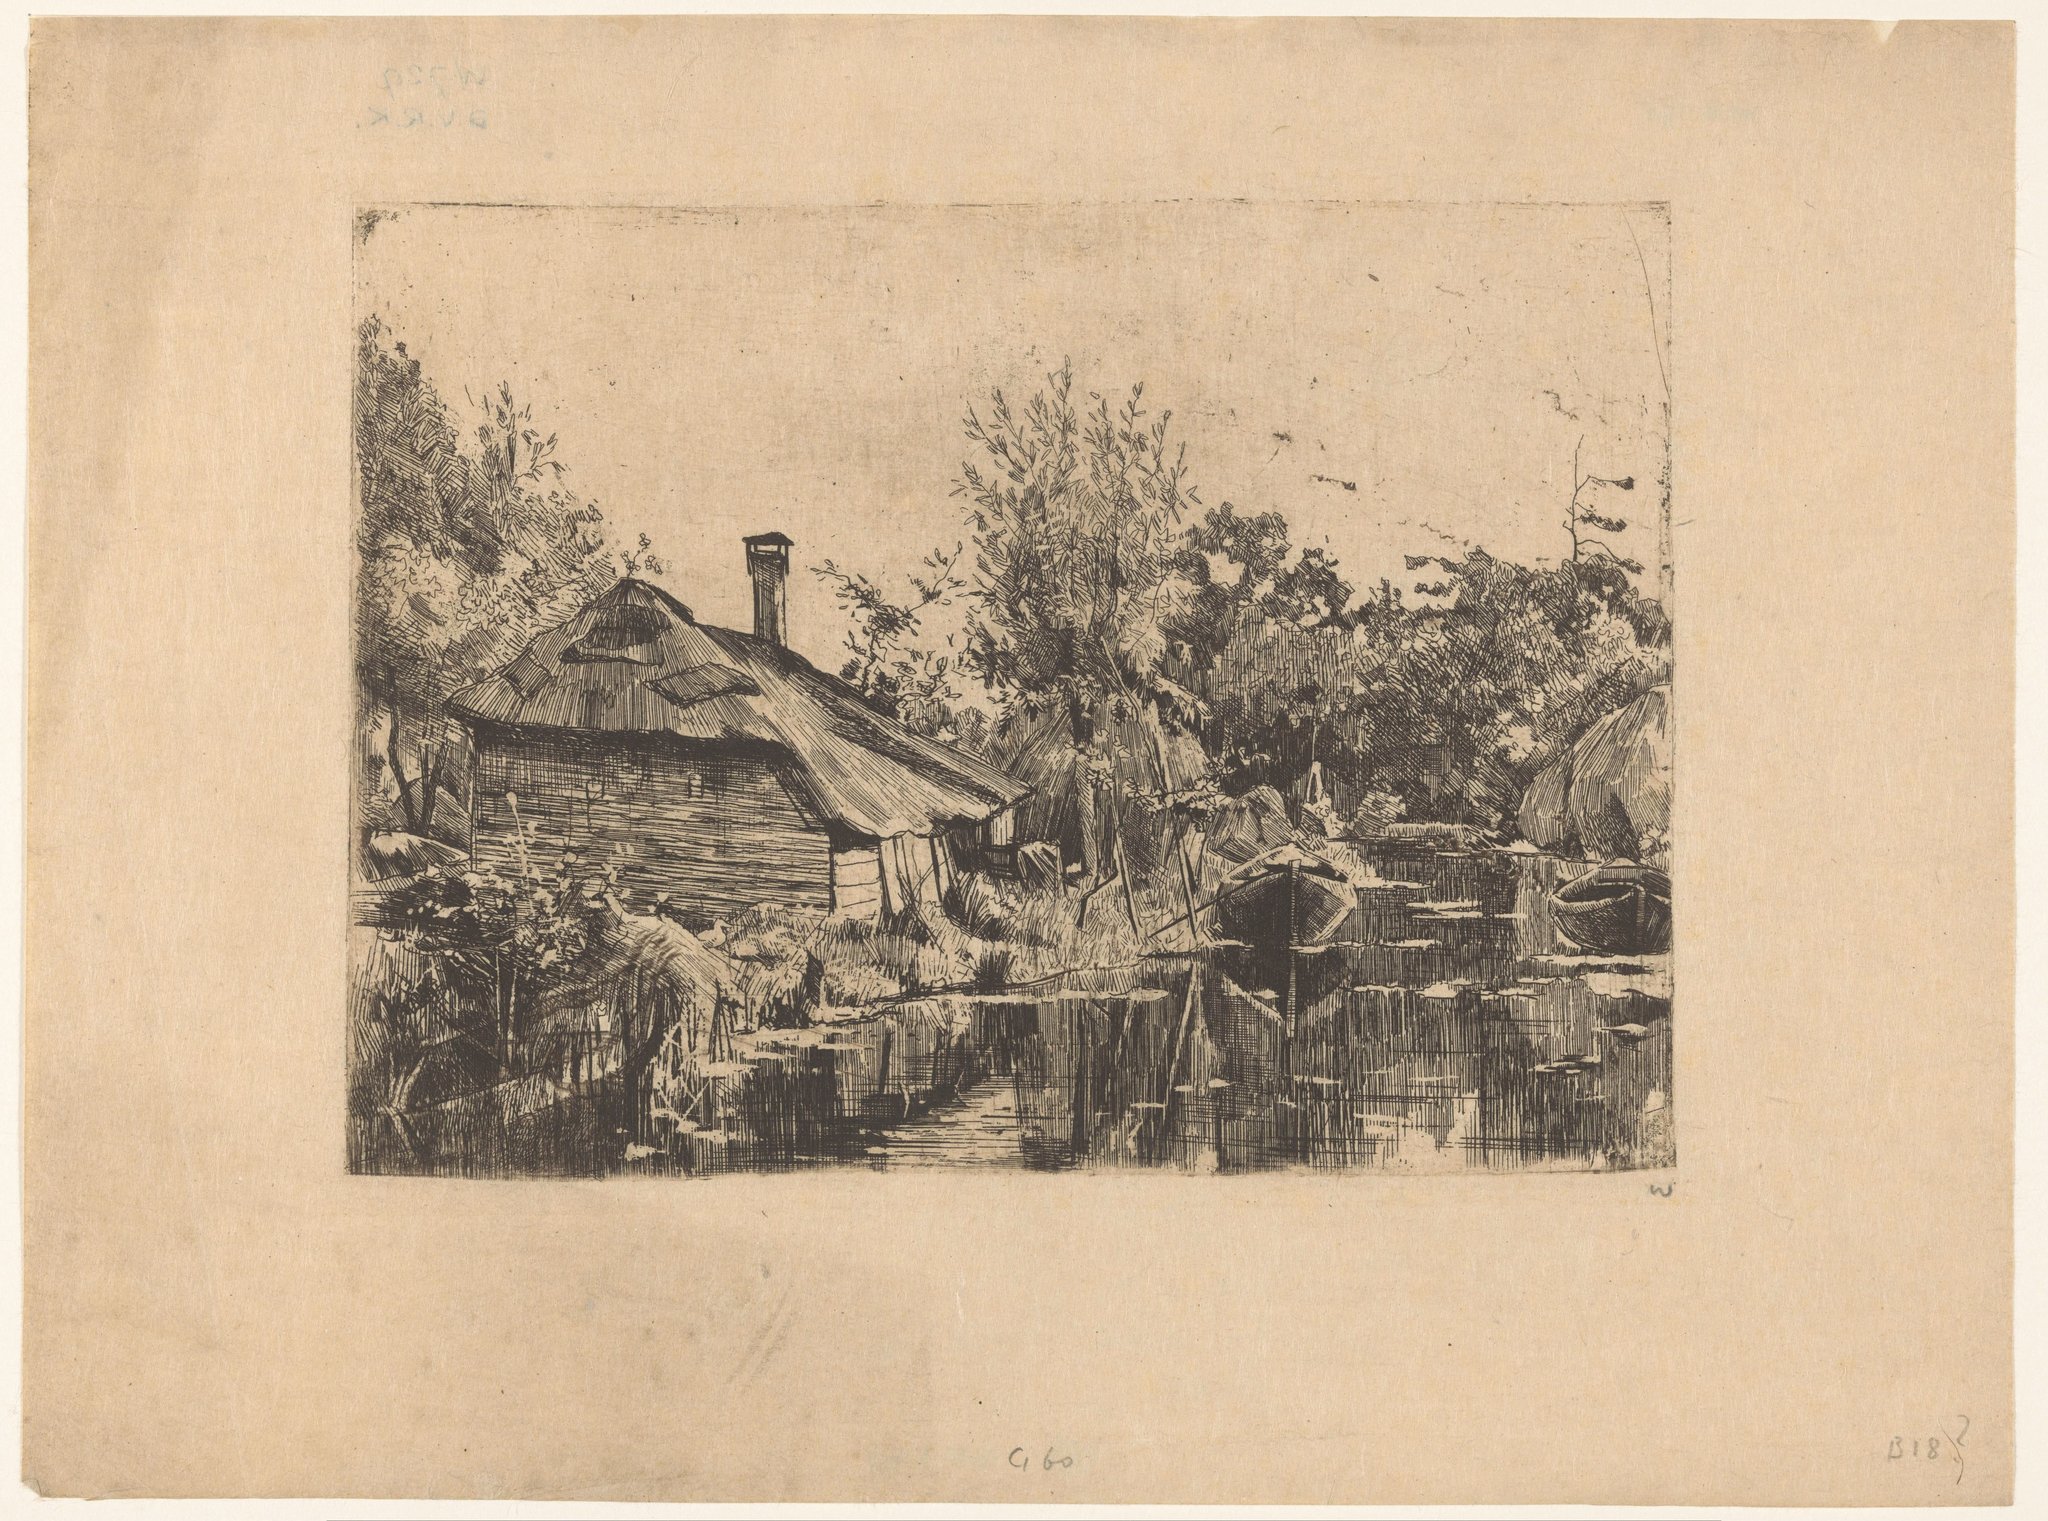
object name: print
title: Huis aan een plas met twee boten in Giethoorn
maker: willem witsen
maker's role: draughtsman, painter, print maker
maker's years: 1860-1923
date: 1885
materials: paper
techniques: etching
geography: giethoorn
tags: rowing-boat, canoe, etc., boat-house, shed, pond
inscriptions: monogram (possibly false): ‘W’